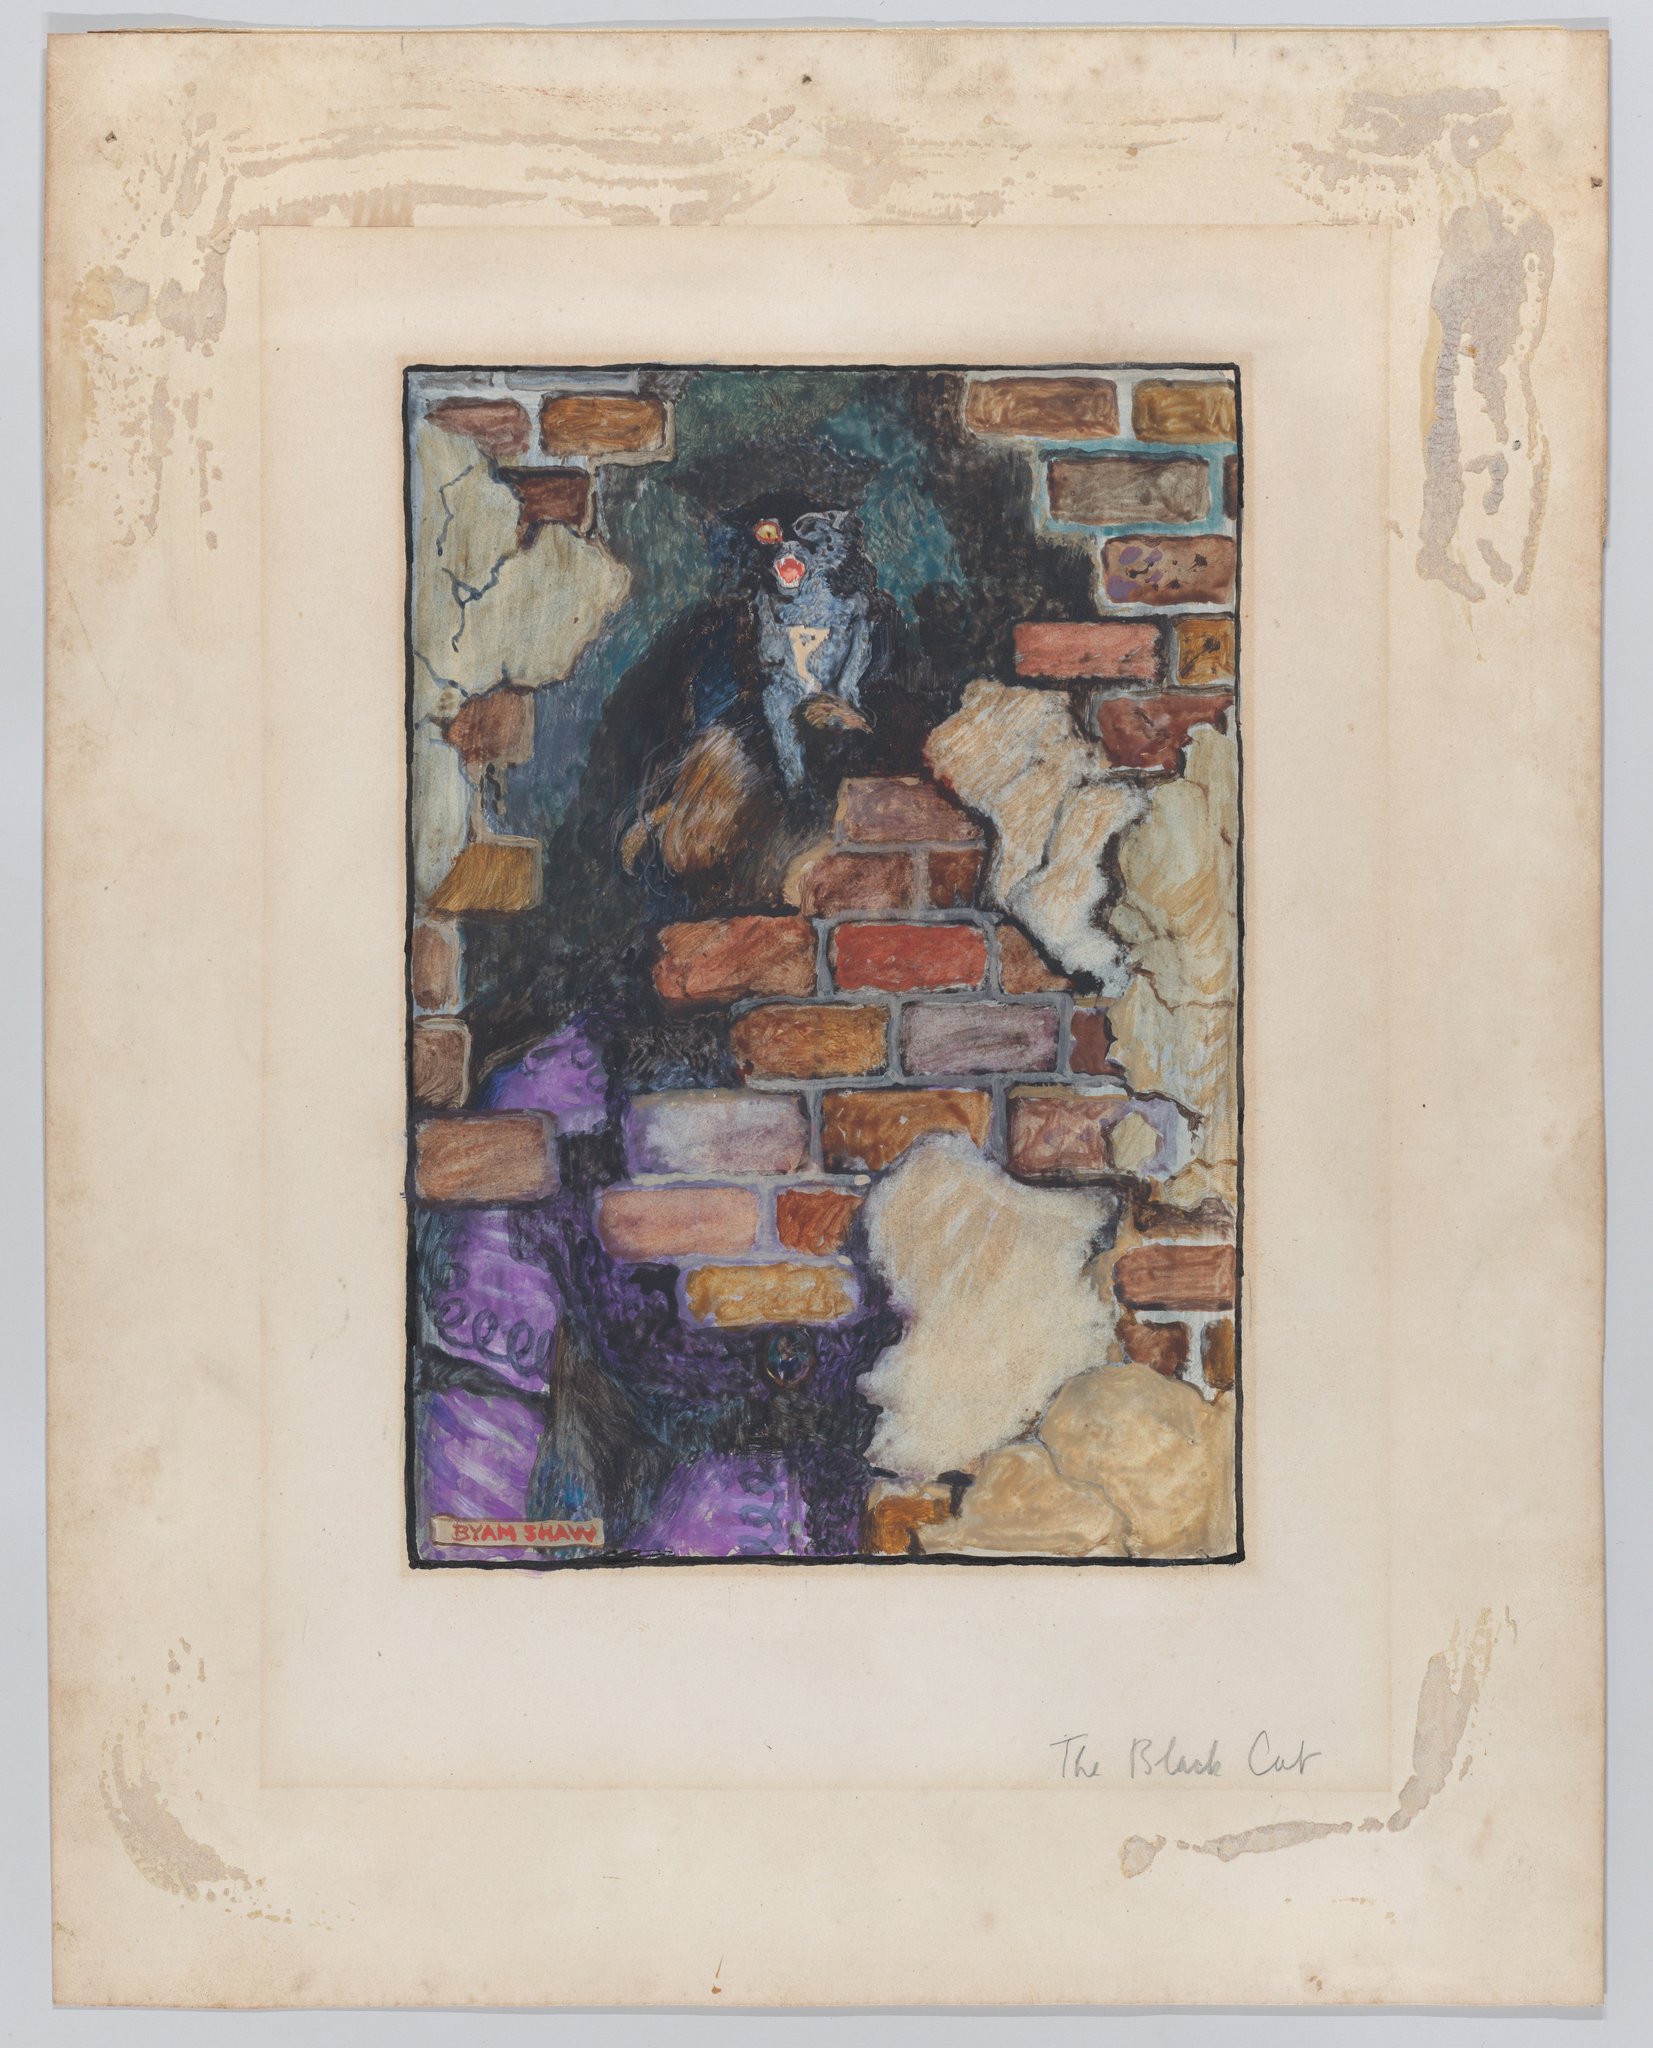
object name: drawing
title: The Black Cat, for Edgar Allan Poe's “Selected Tales of Mystery"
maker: john byam liston shaw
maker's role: artist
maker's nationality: british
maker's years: 1872-1919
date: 1909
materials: gouache, watercolor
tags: cats